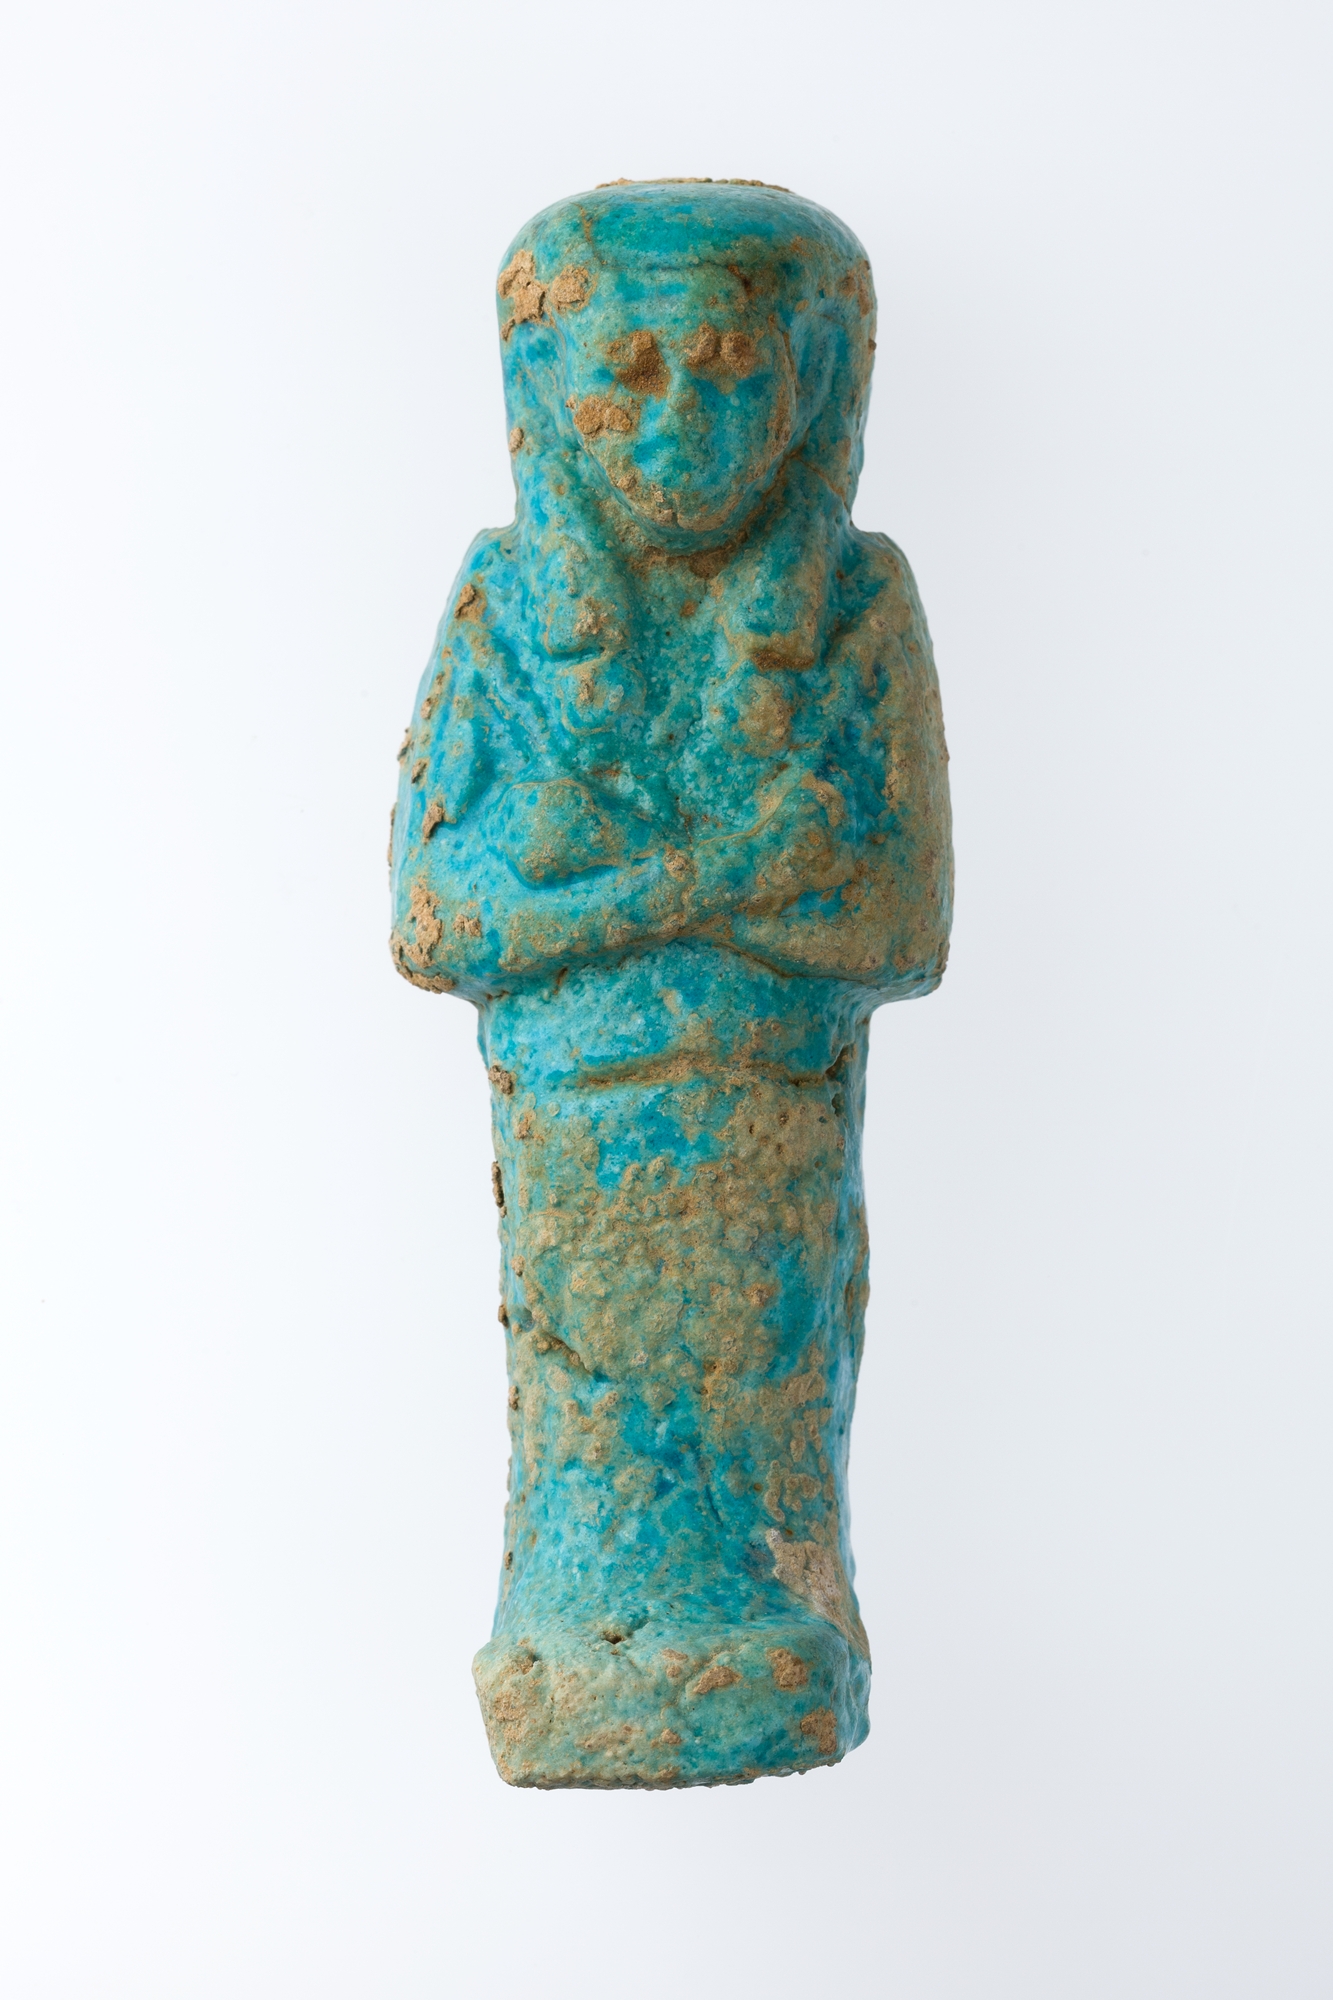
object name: shabti, henettawy c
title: Worker Shabti of Henettawy (C), Daughter of Isetemkheb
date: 990-970 BCE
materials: faience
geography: egypt